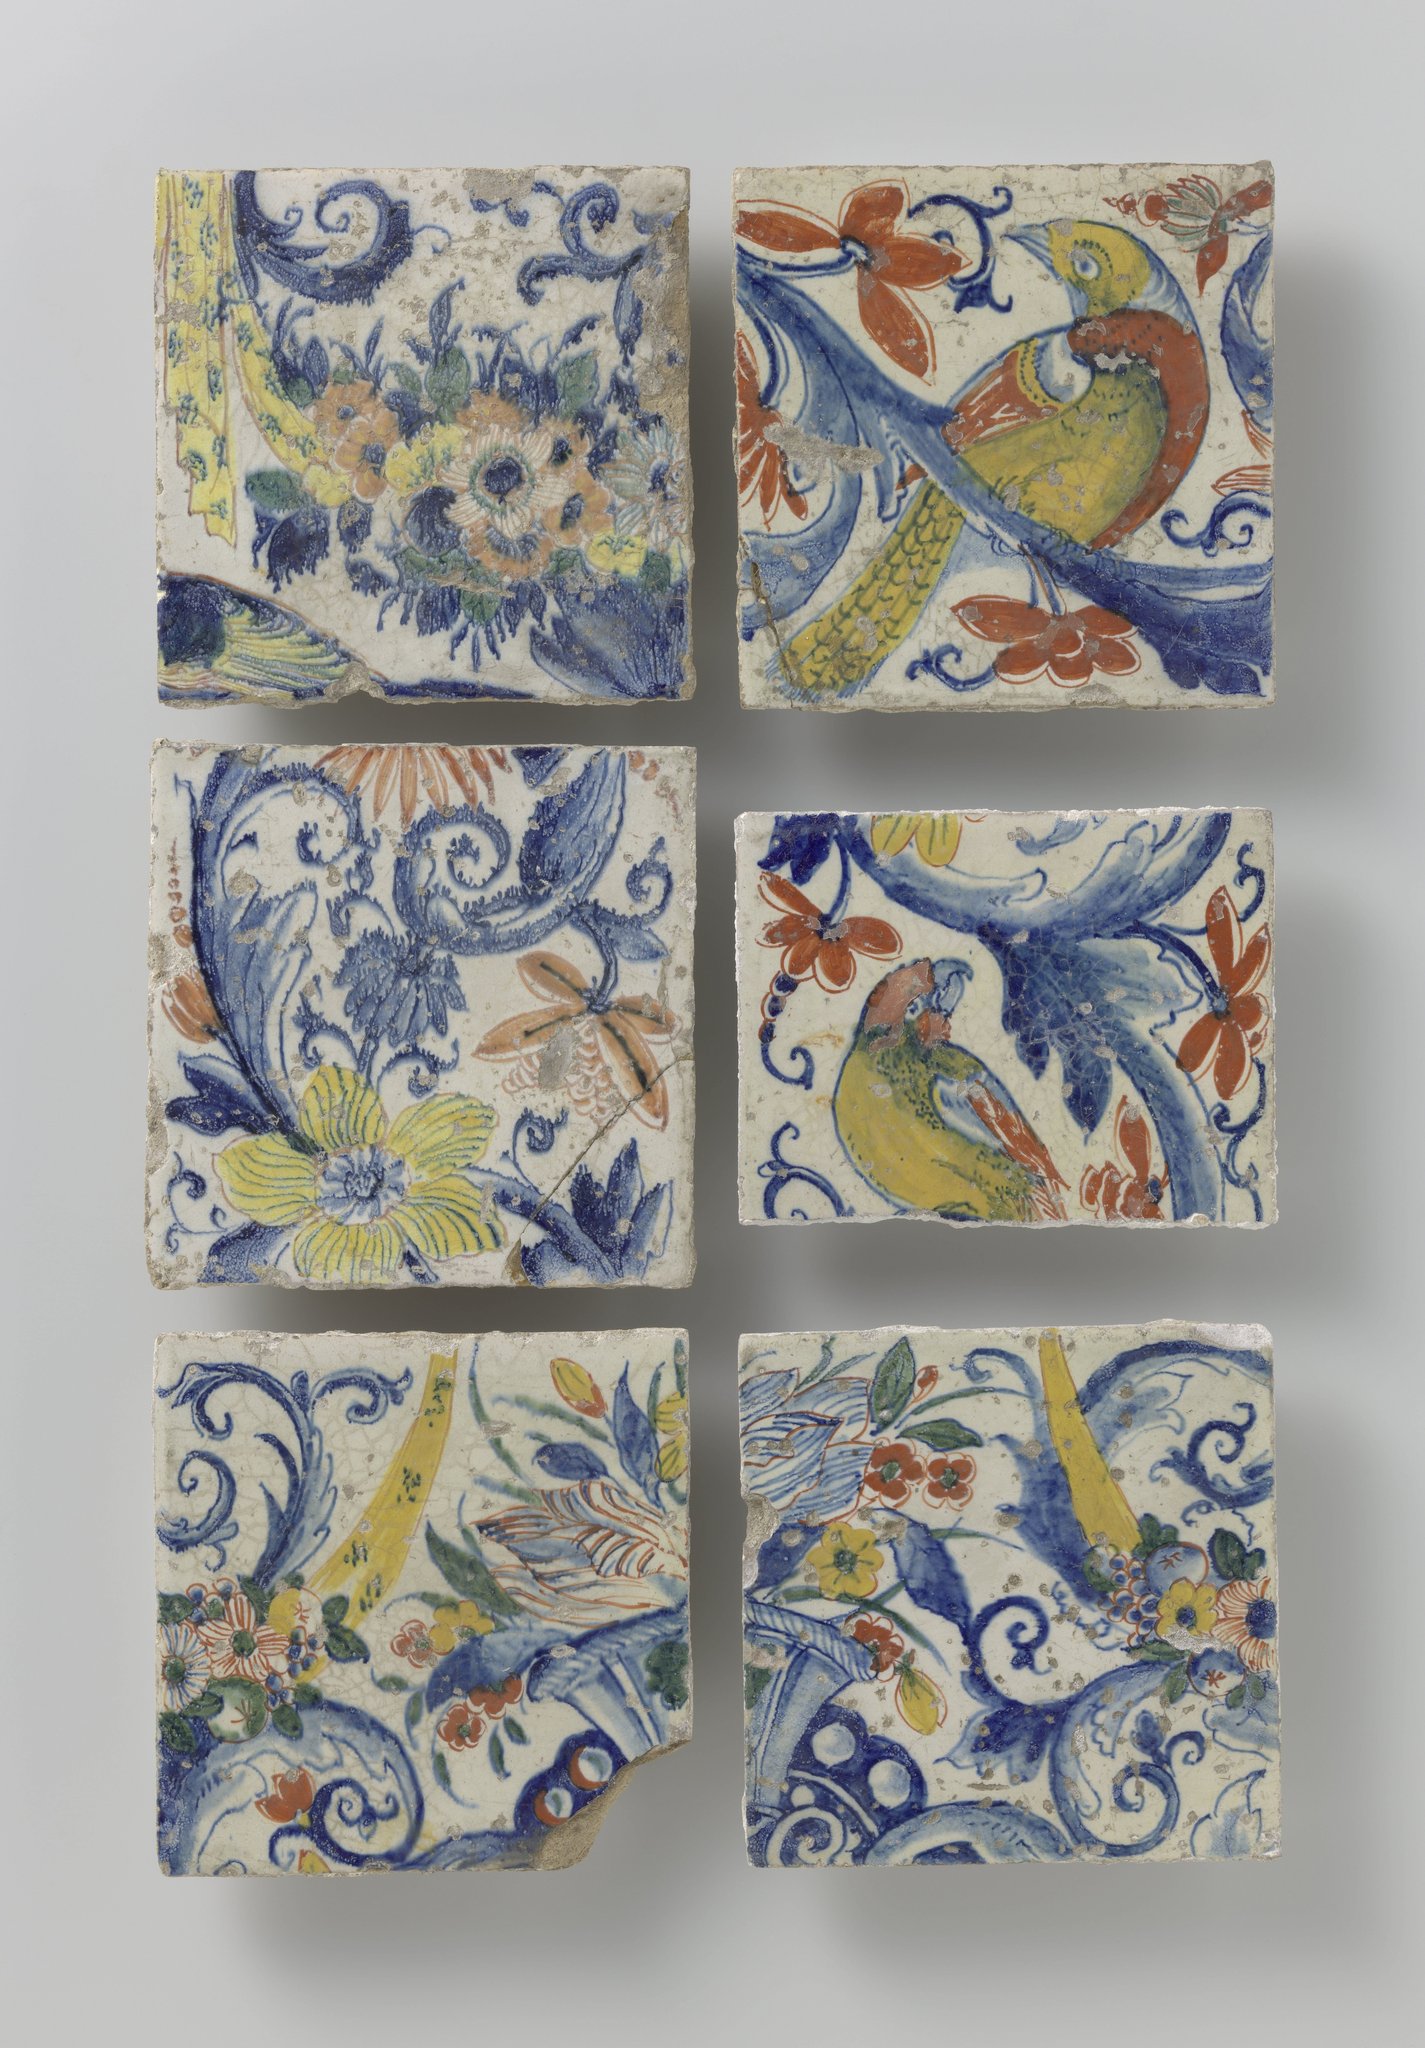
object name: tile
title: Vijf tegels en een fragment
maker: Anonymous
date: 1720-1760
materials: earthenware, glaze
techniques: maiolica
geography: netherlands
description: Vijf tegels en een fragment met een veelkleurige (blauw, rood, geel en groen) voorstelling van vogels tussen bloem- en bladranken.